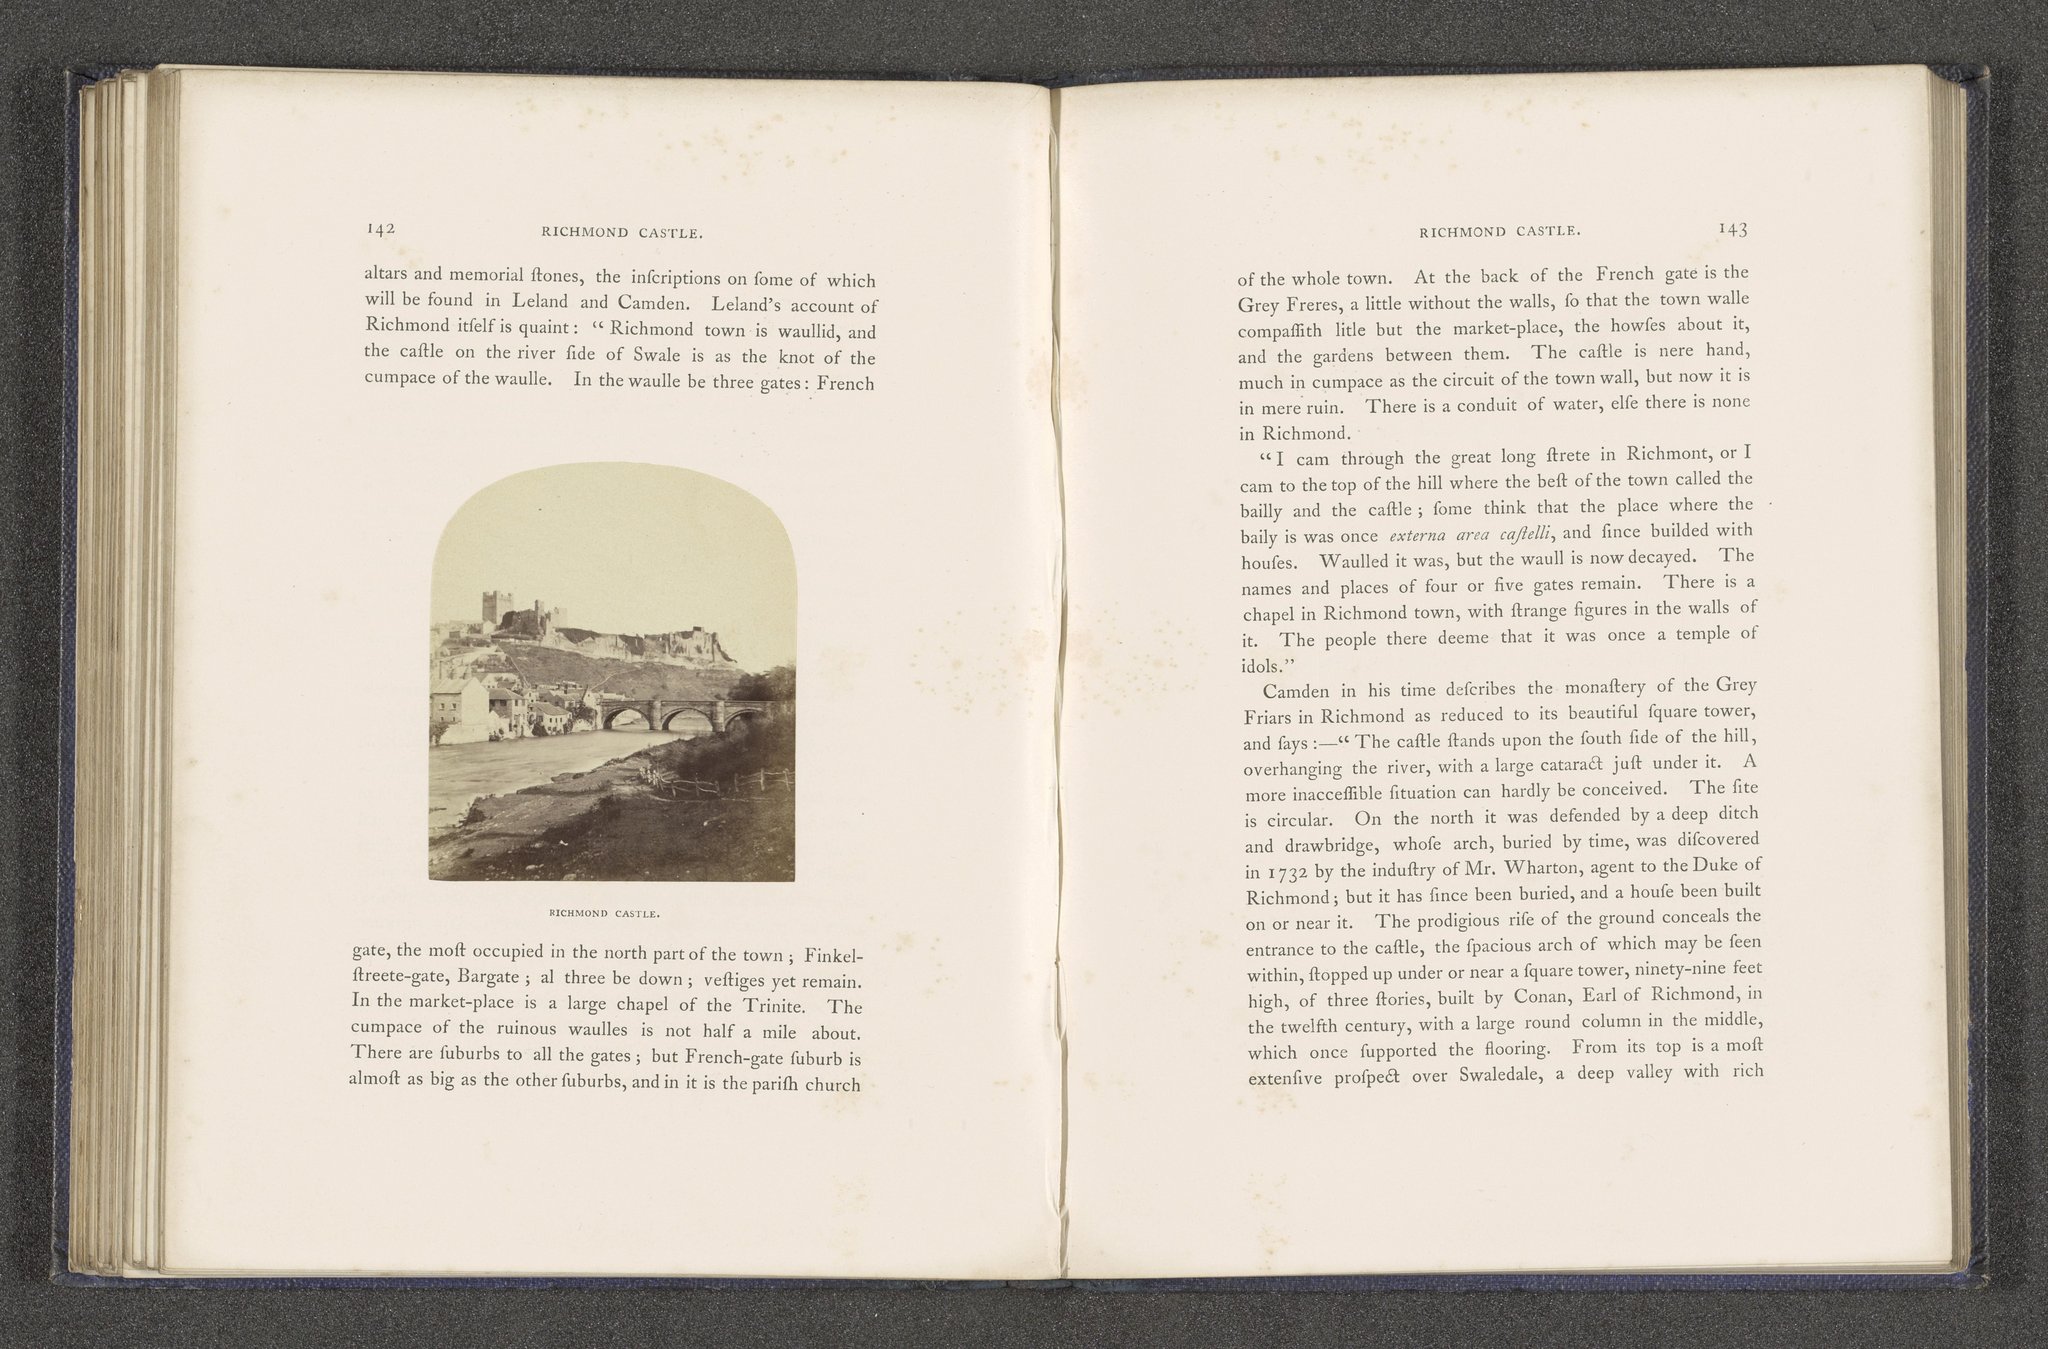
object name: photograph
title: Richmond Castle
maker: william russell sedgfield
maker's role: fotograaf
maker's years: 1826-1902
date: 1854-1864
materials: photographic support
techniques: albumen print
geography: richmond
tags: ruin of a dwelling, house, castle, etc.